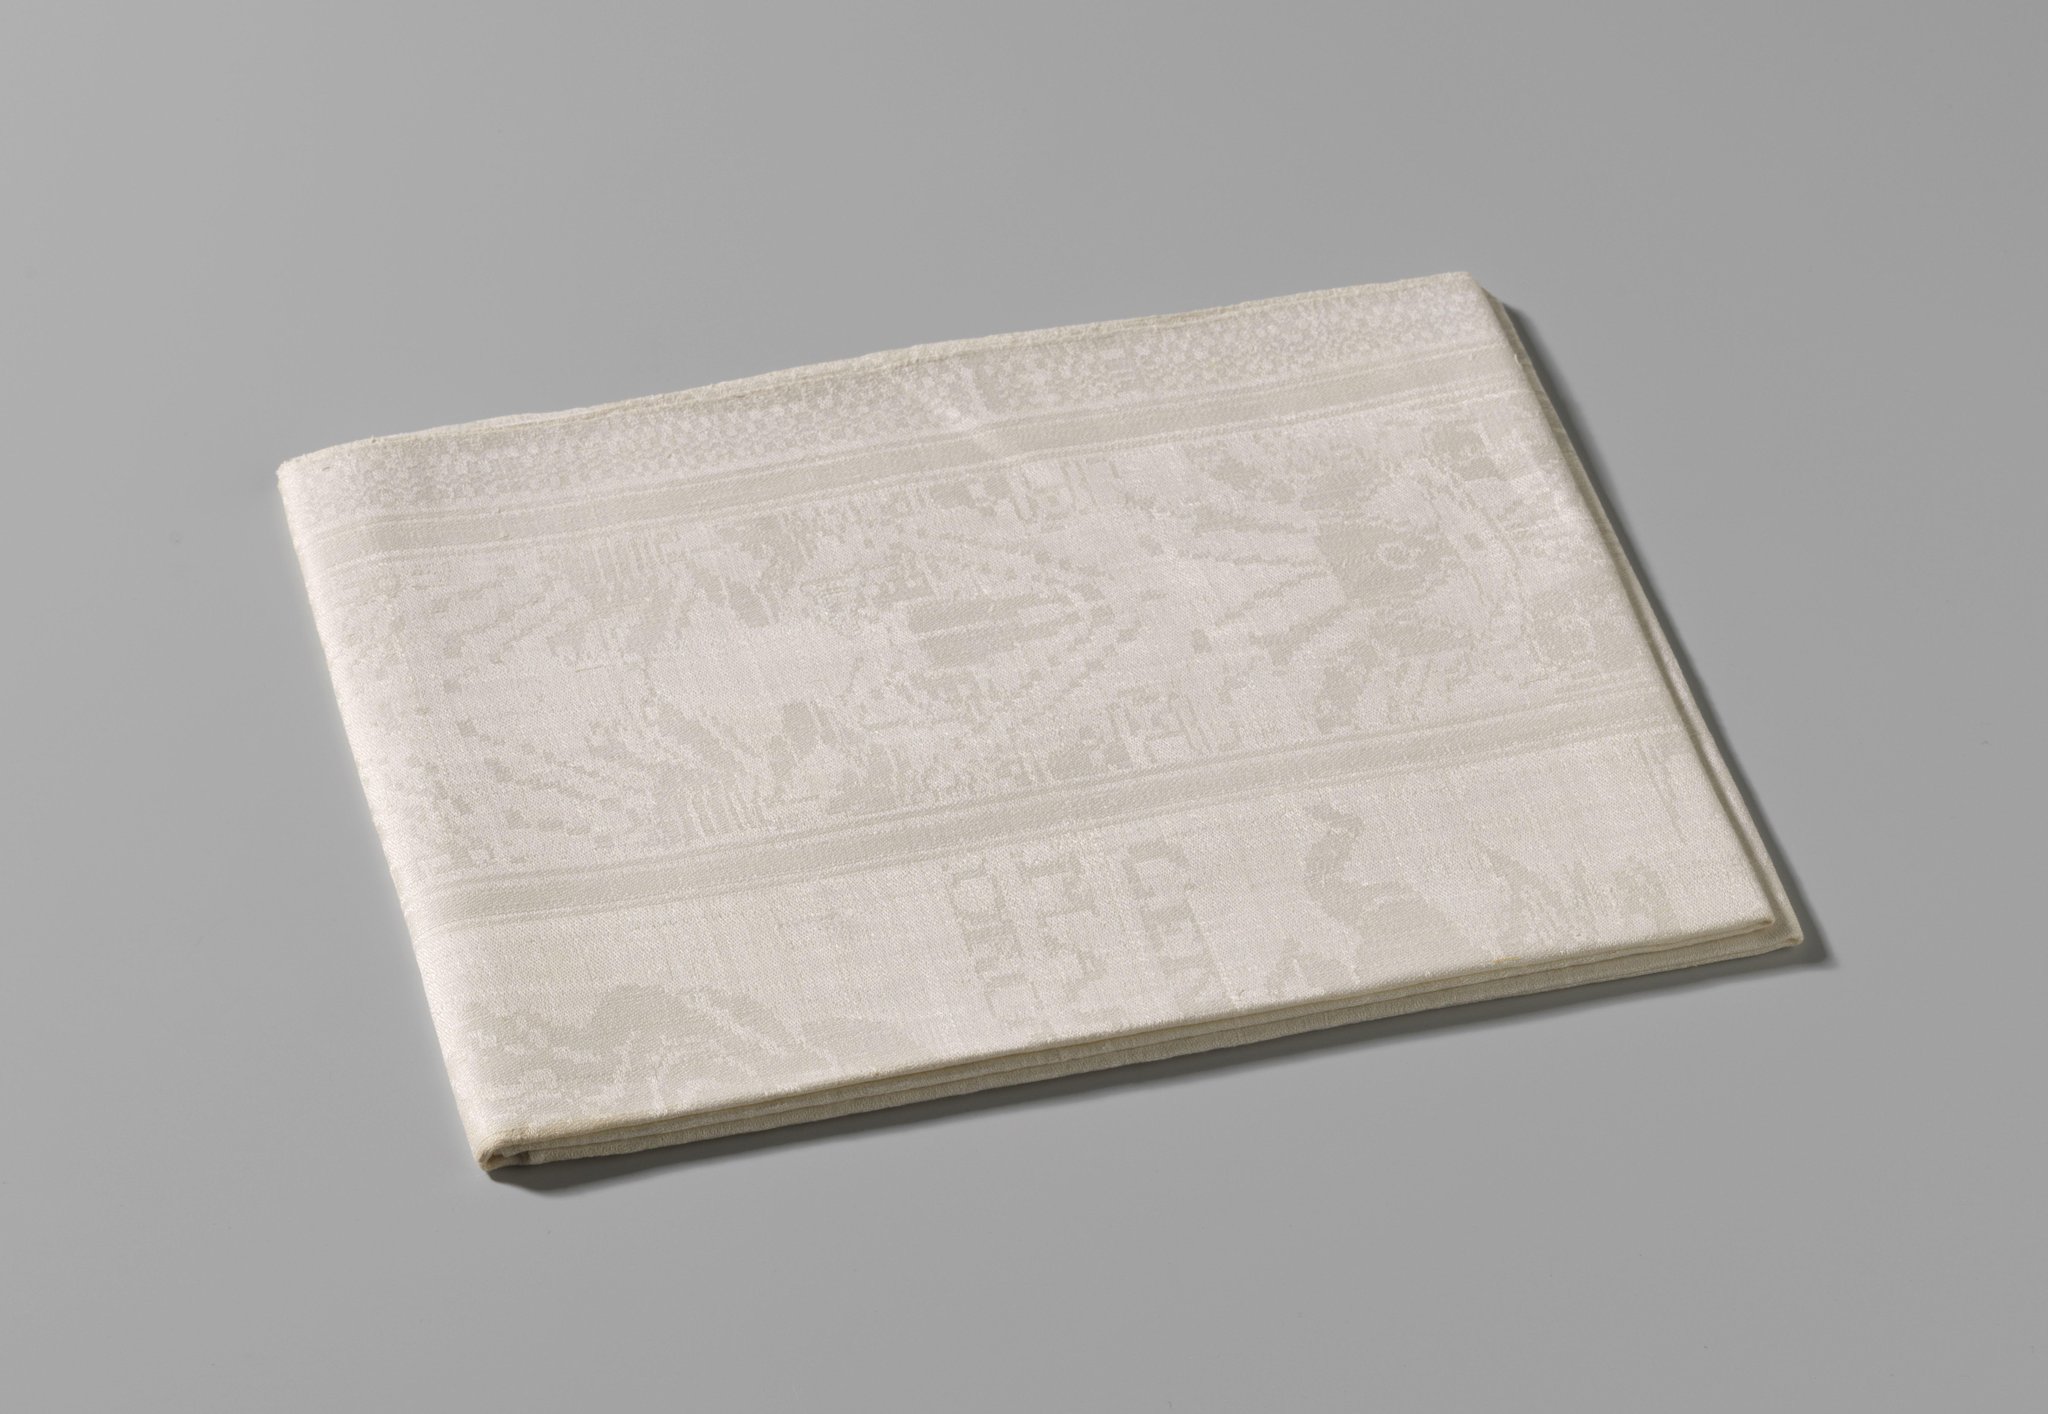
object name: napkin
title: Servet met de slag bij Malplaquet en het ruiterportret en wapen van John Churchill hertog van Marlborough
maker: Anonymous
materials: linen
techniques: damask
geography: kortrijk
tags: eugenius van savoye, john churchill (1e hertog van marlborough)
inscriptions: mark: ‘12’, mark: ‘AEK’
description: Servet van linnendamast met de slag bij Malplaquet en het ruiterportret en wapen van John Churchill hertog van Marlborough. Ingeweven: GEN/ MARLB/ OROUG en MALPLAQUE.